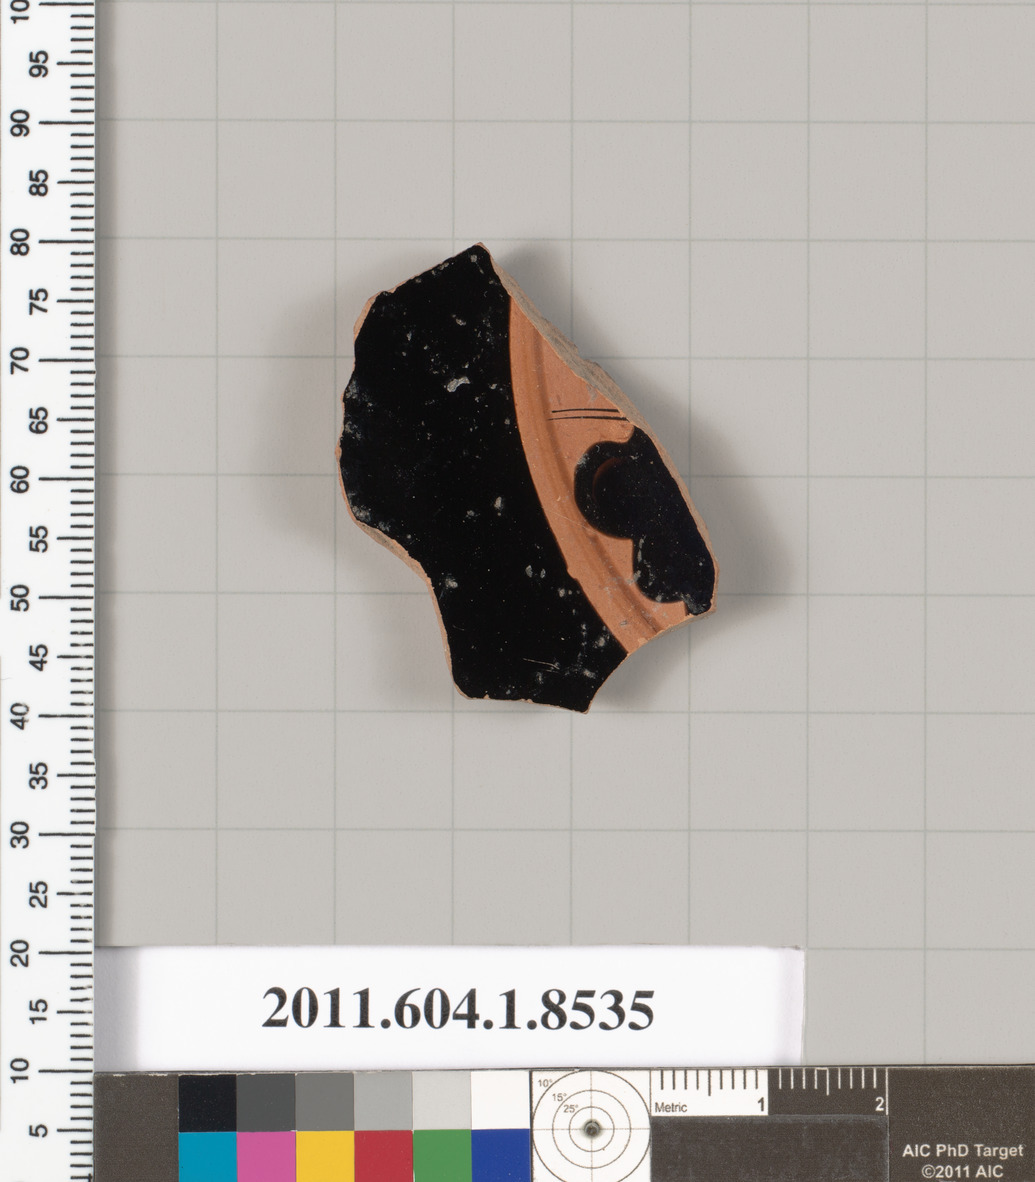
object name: kylix fragment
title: Terracotta fragment of a stemless kylix (drinking cup)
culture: greek, attic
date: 460-450 BCE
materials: terracotta